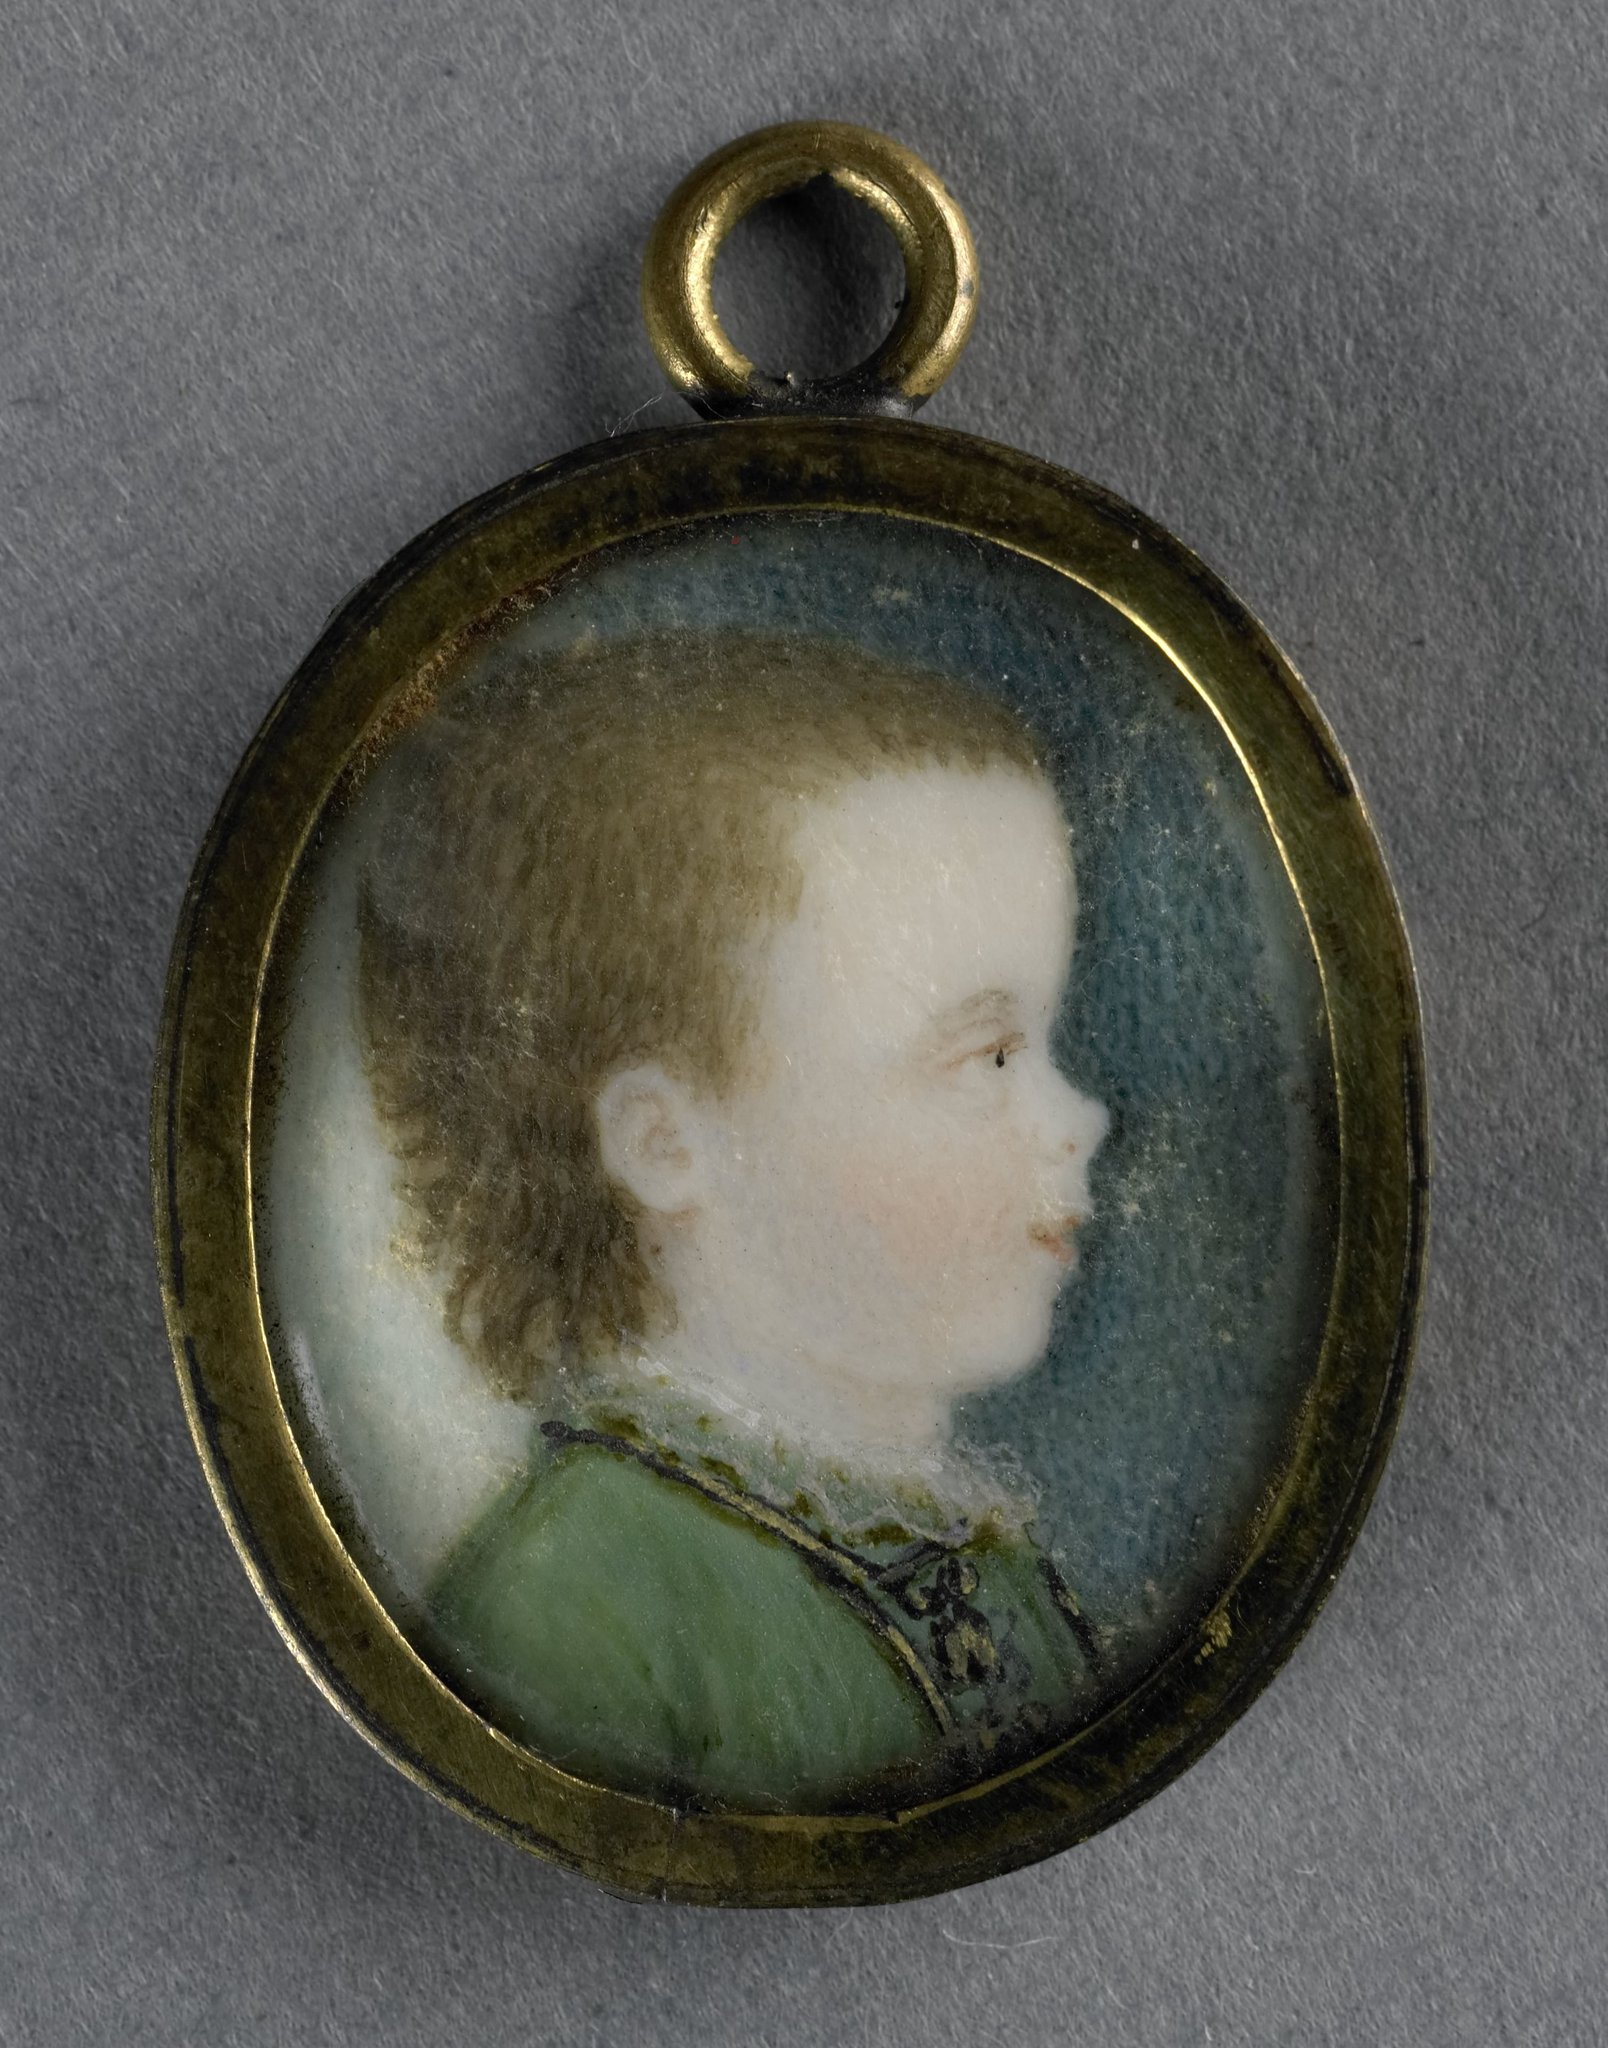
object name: painting, miniature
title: Willem George Frederik (1774-1799), prins van Oranje-Nassau. Zoon van Willem V en Wilhelmina van Pruisen, als kind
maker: pieter le sage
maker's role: miniatuurschilder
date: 1775-1780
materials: glass, ivory, metal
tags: willem george frederik (prins van oranje-nassau)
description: William George Frederick, son of William V and Wilhelmina of Prussia, by P. Lesage.